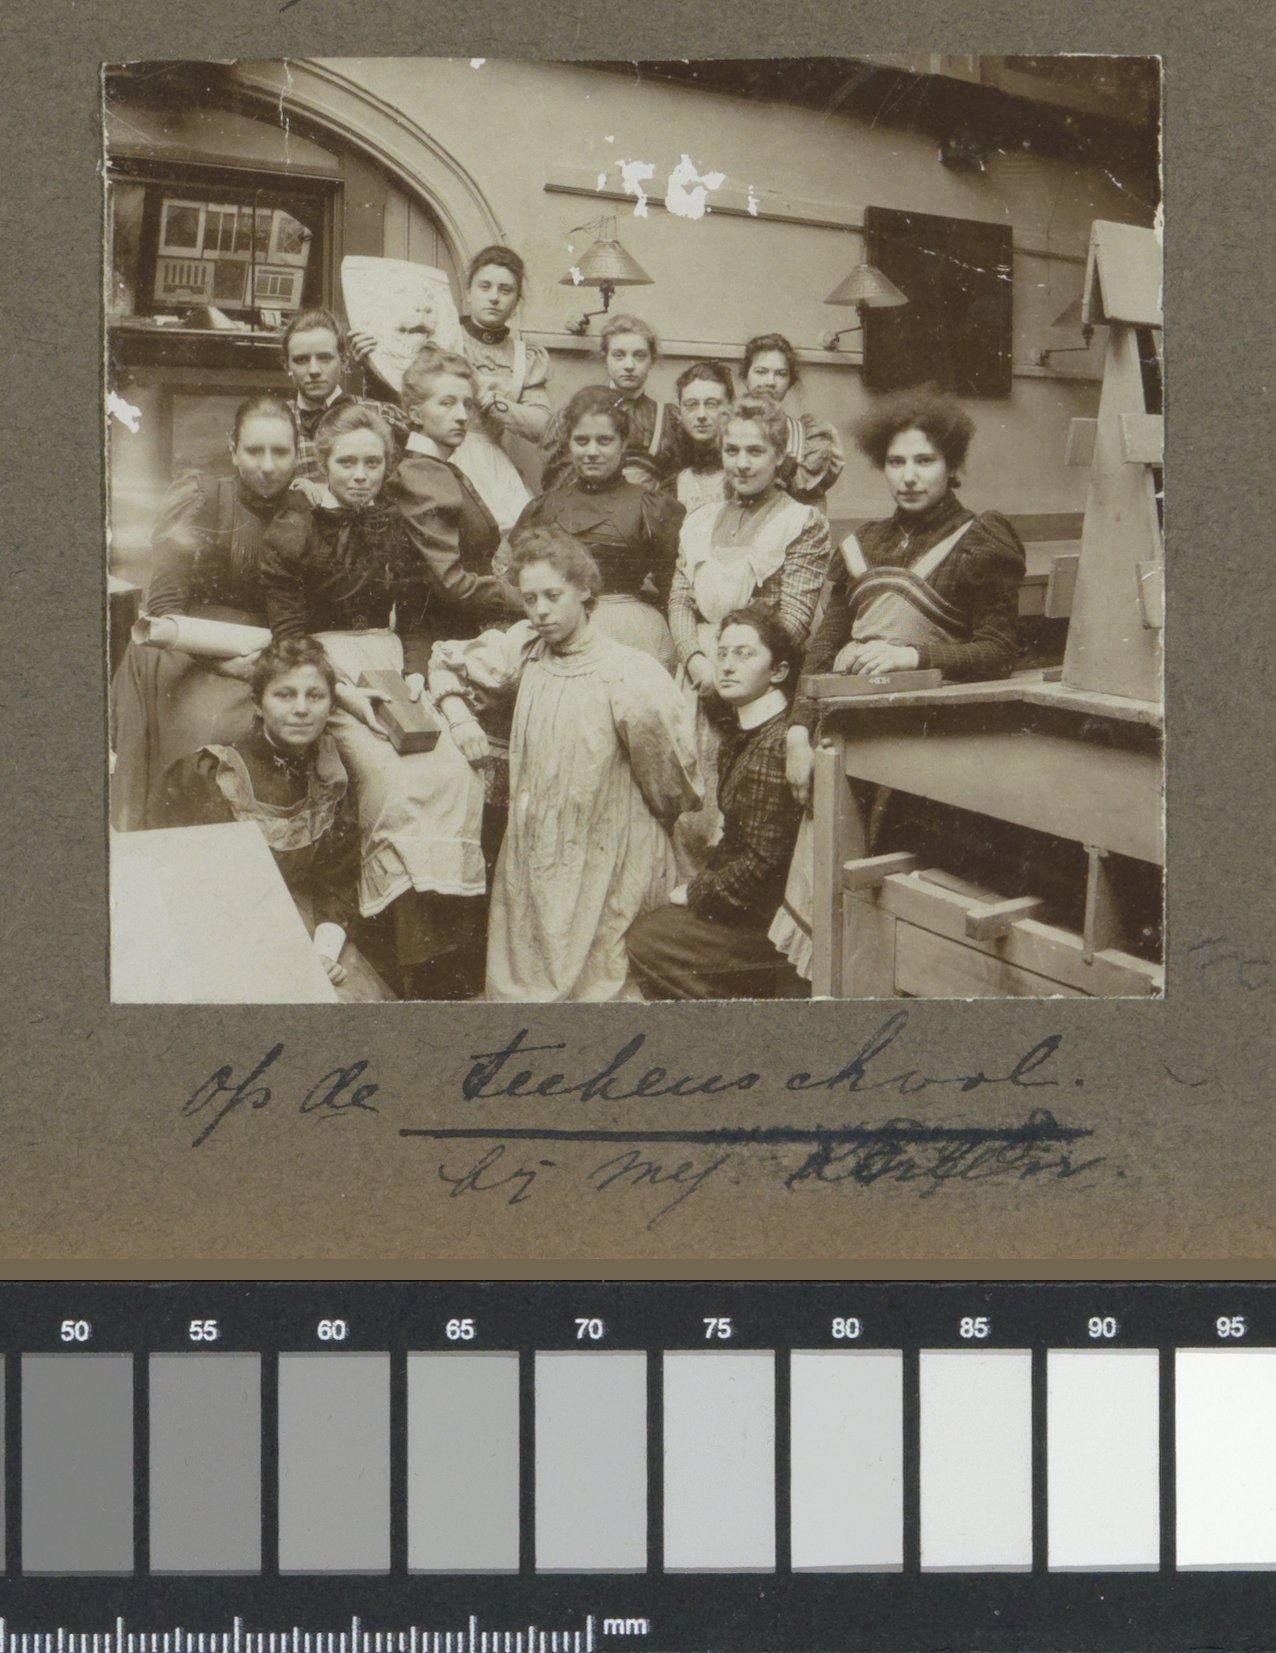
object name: photograph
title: Groepsportret van jonge vrouwen in een tekenschool, vermoedelijk in Nederland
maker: Anonymous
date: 1910-1930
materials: photographic support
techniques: collodion silver print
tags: adult woman, drawing-lesson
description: Onderdeel van fotoalbum van een onbekende Nederlandse familie met opnames van Suriname, Europa en Nederlands-Indië.